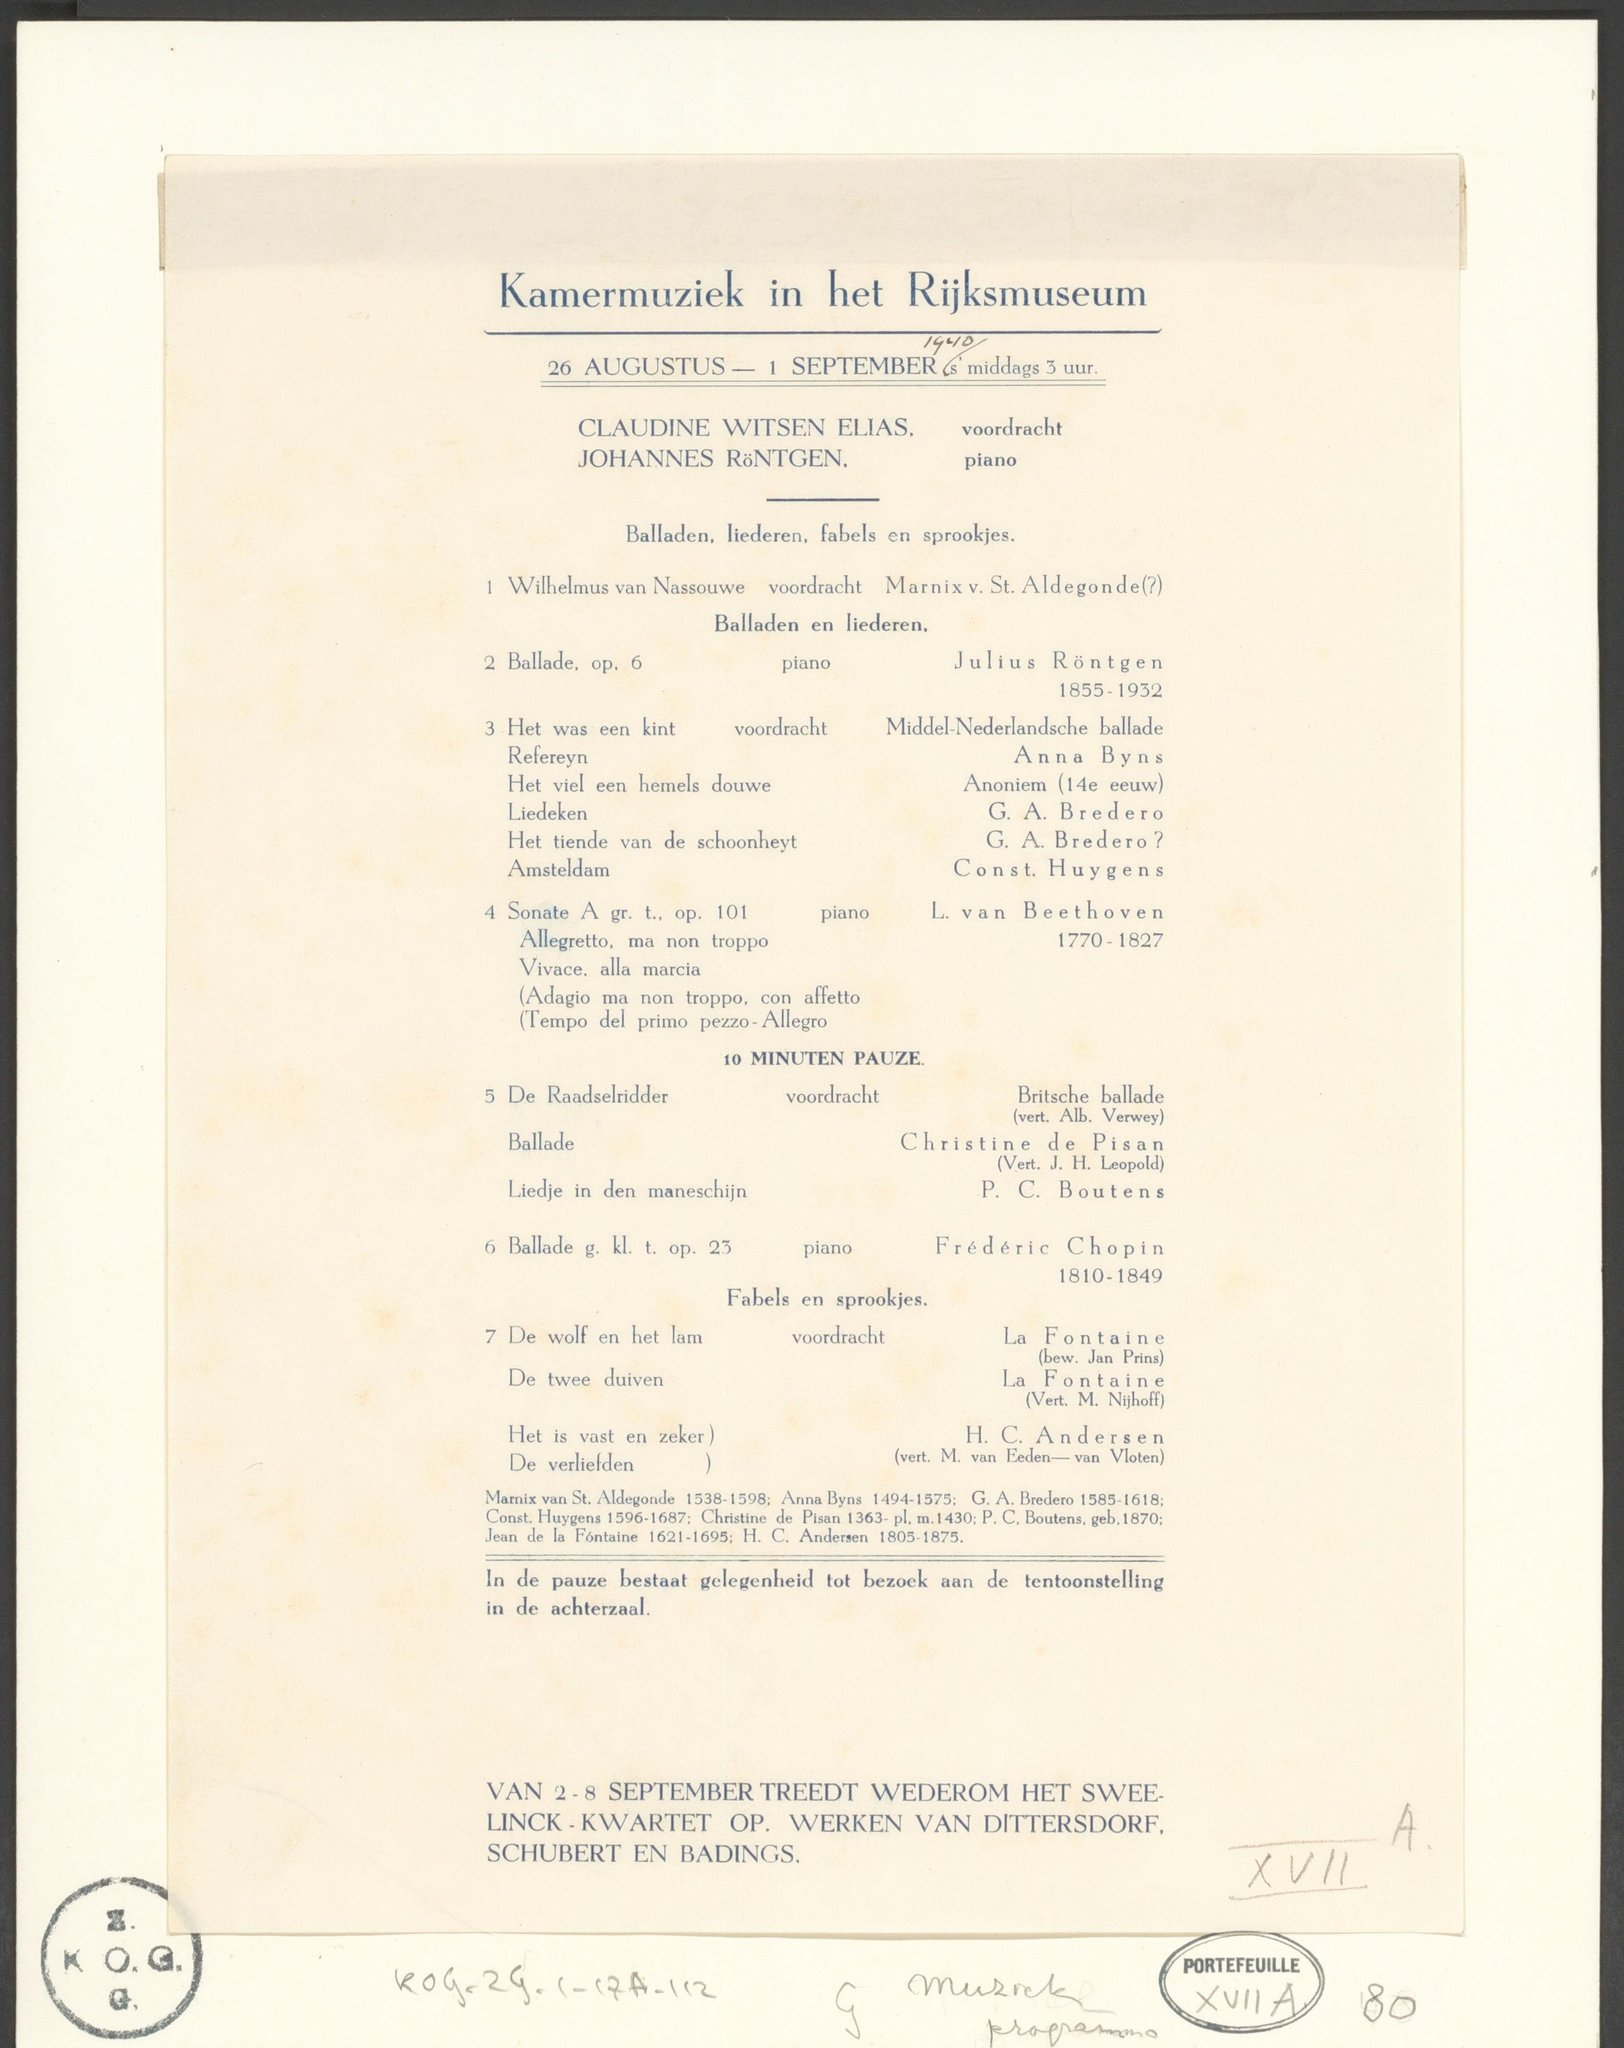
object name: programma, programmaboekje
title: Programma voor een uitvoering van kamermuziek in het Rijksmuseum, 26 augustus - 1 september 1940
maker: Anonymous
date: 1940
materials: paper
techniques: letterpress printing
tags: small group of musicians, chamber orchestra, jazz band, listening to music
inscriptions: collector's mark: Lugt 1641, collector's mark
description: Gedrukt programma voor een uitvoering van kamermuziek in het Rijksmuseum te Amsterdam, 26 augustus - 1 september 1940. Door Claudine Witsen Elias (voordracht) en Johannes Röntgen (piano). Onderwerpsrubrieken binnen de Atlas Zeden en Gewoonten: Muziek en muziekinstrumenten: Varia.